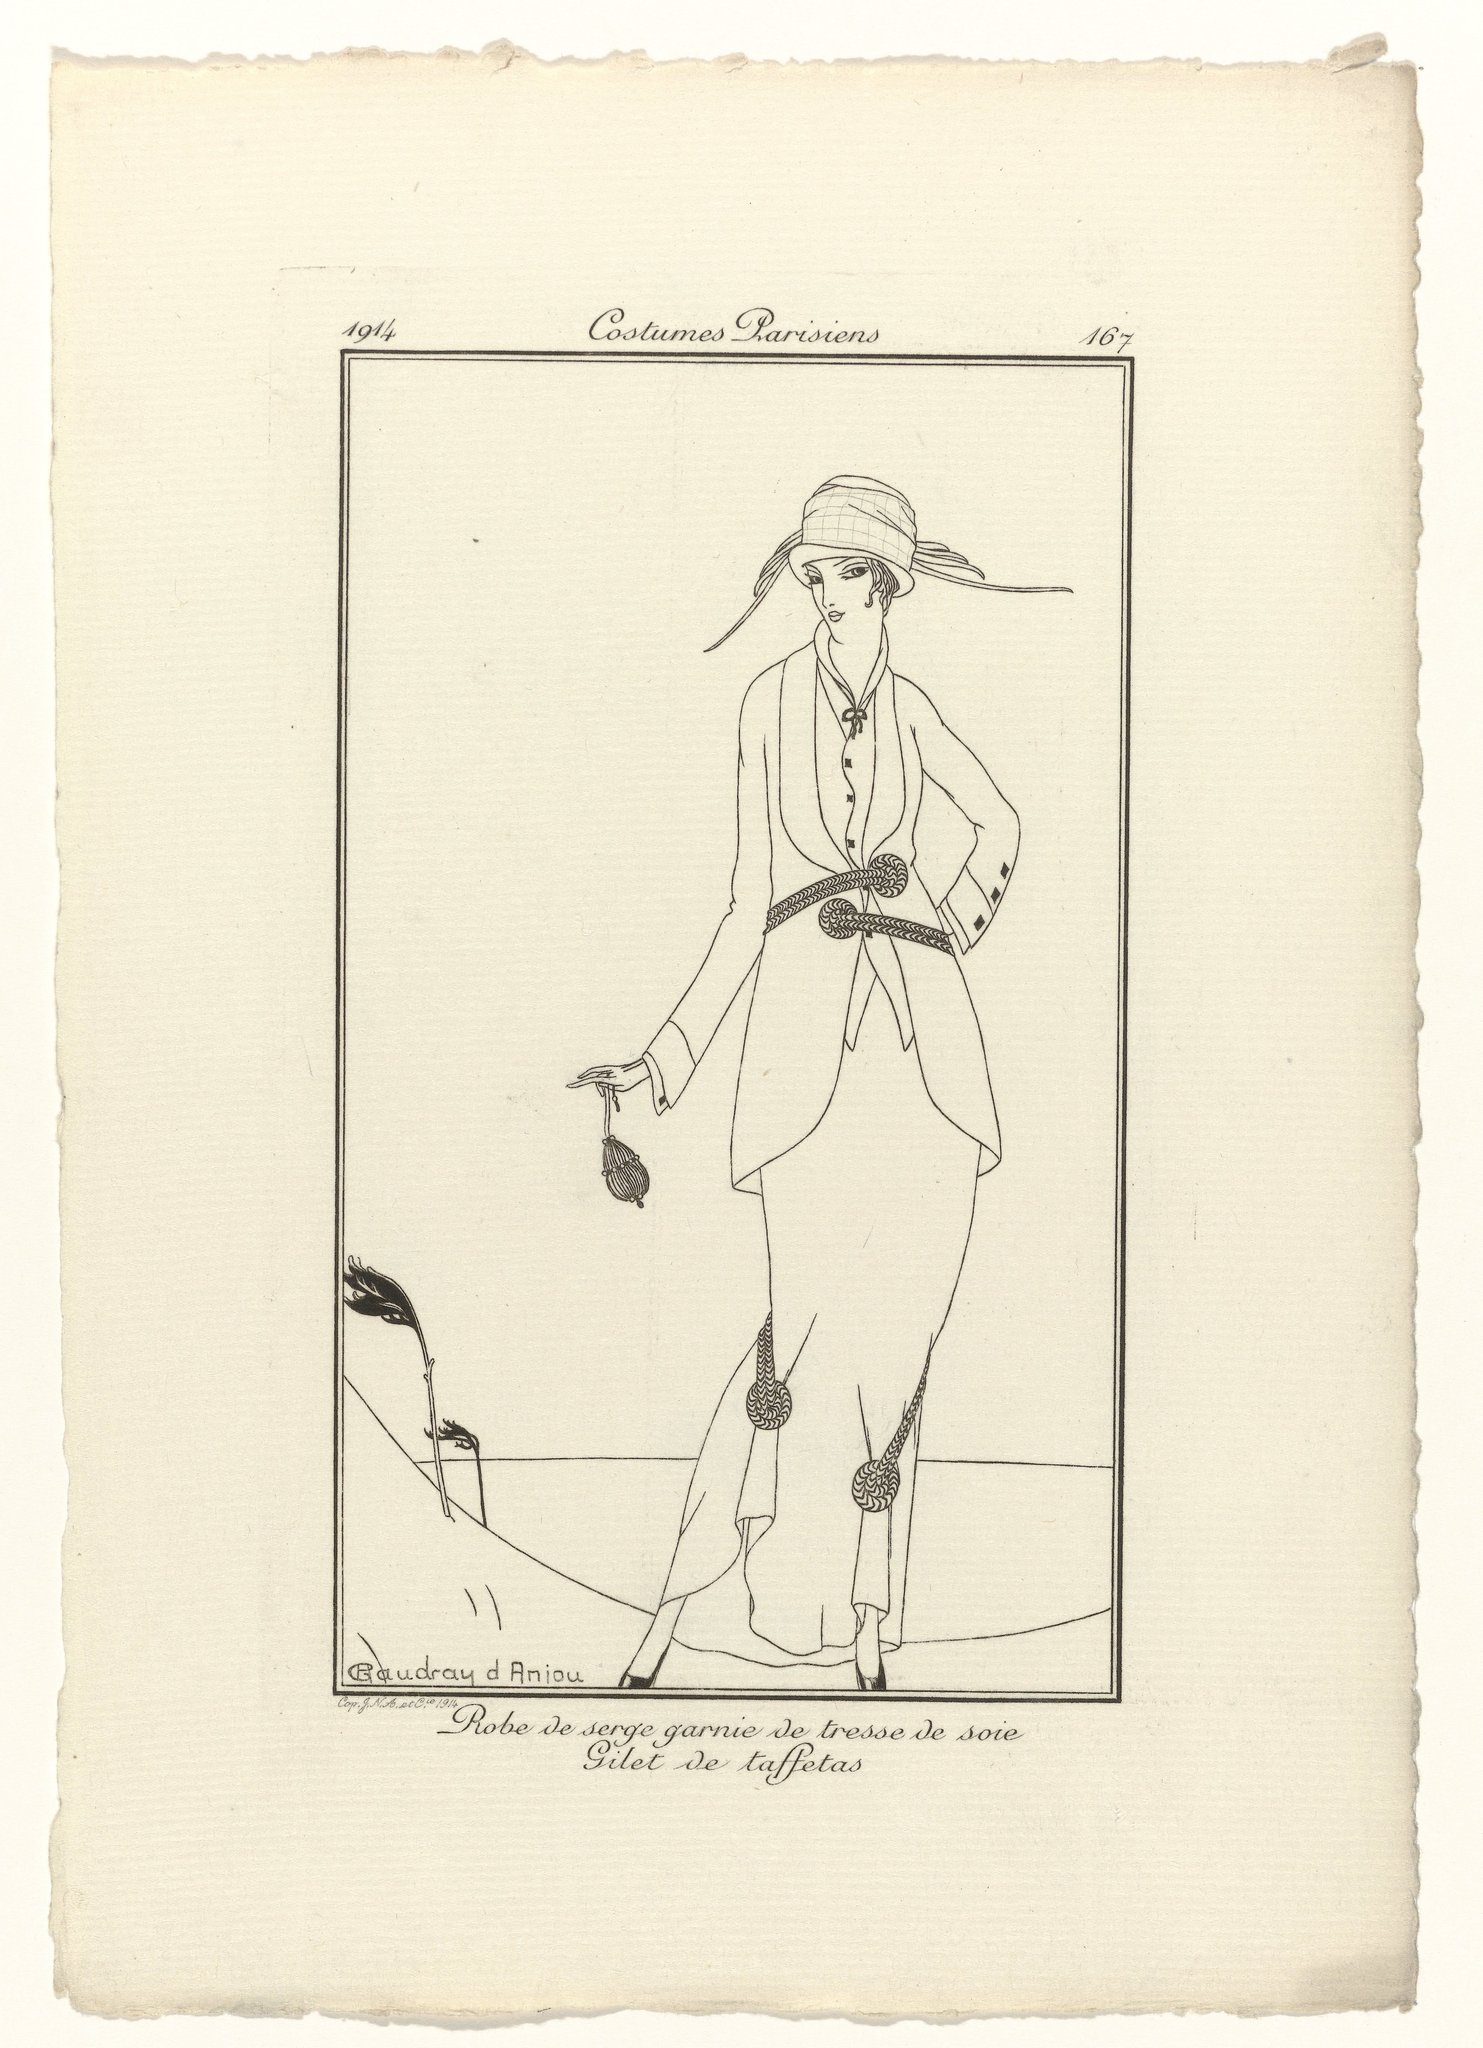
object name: fashion print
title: Journal des Dames et des Modes, Costumes Parisiens, 1914, No. 167 : Robe de serg (...)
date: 1914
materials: paper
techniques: engraving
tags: ornamental parts of clothing (+ women's clothes), bag (handbag) (+ women's clothes), clothing for the upper part of the body (vest) (+ women's clothes), fashion plates, dress, gown (+ women's clothes)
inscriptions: caption: ‘Robe de serge garnie de tresse de soie Gilet de taffetas.’, inscription: ‘Cop. J. N. A. et Cie 1914’, title: ‘Costumes Parisiens’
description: Ensemble van serge versierd met koorden van zijde. Vest van tafzijde. Proefdruk van een prent uit het modetijdschrift Journal des Dames et des Modes (1912-1914).